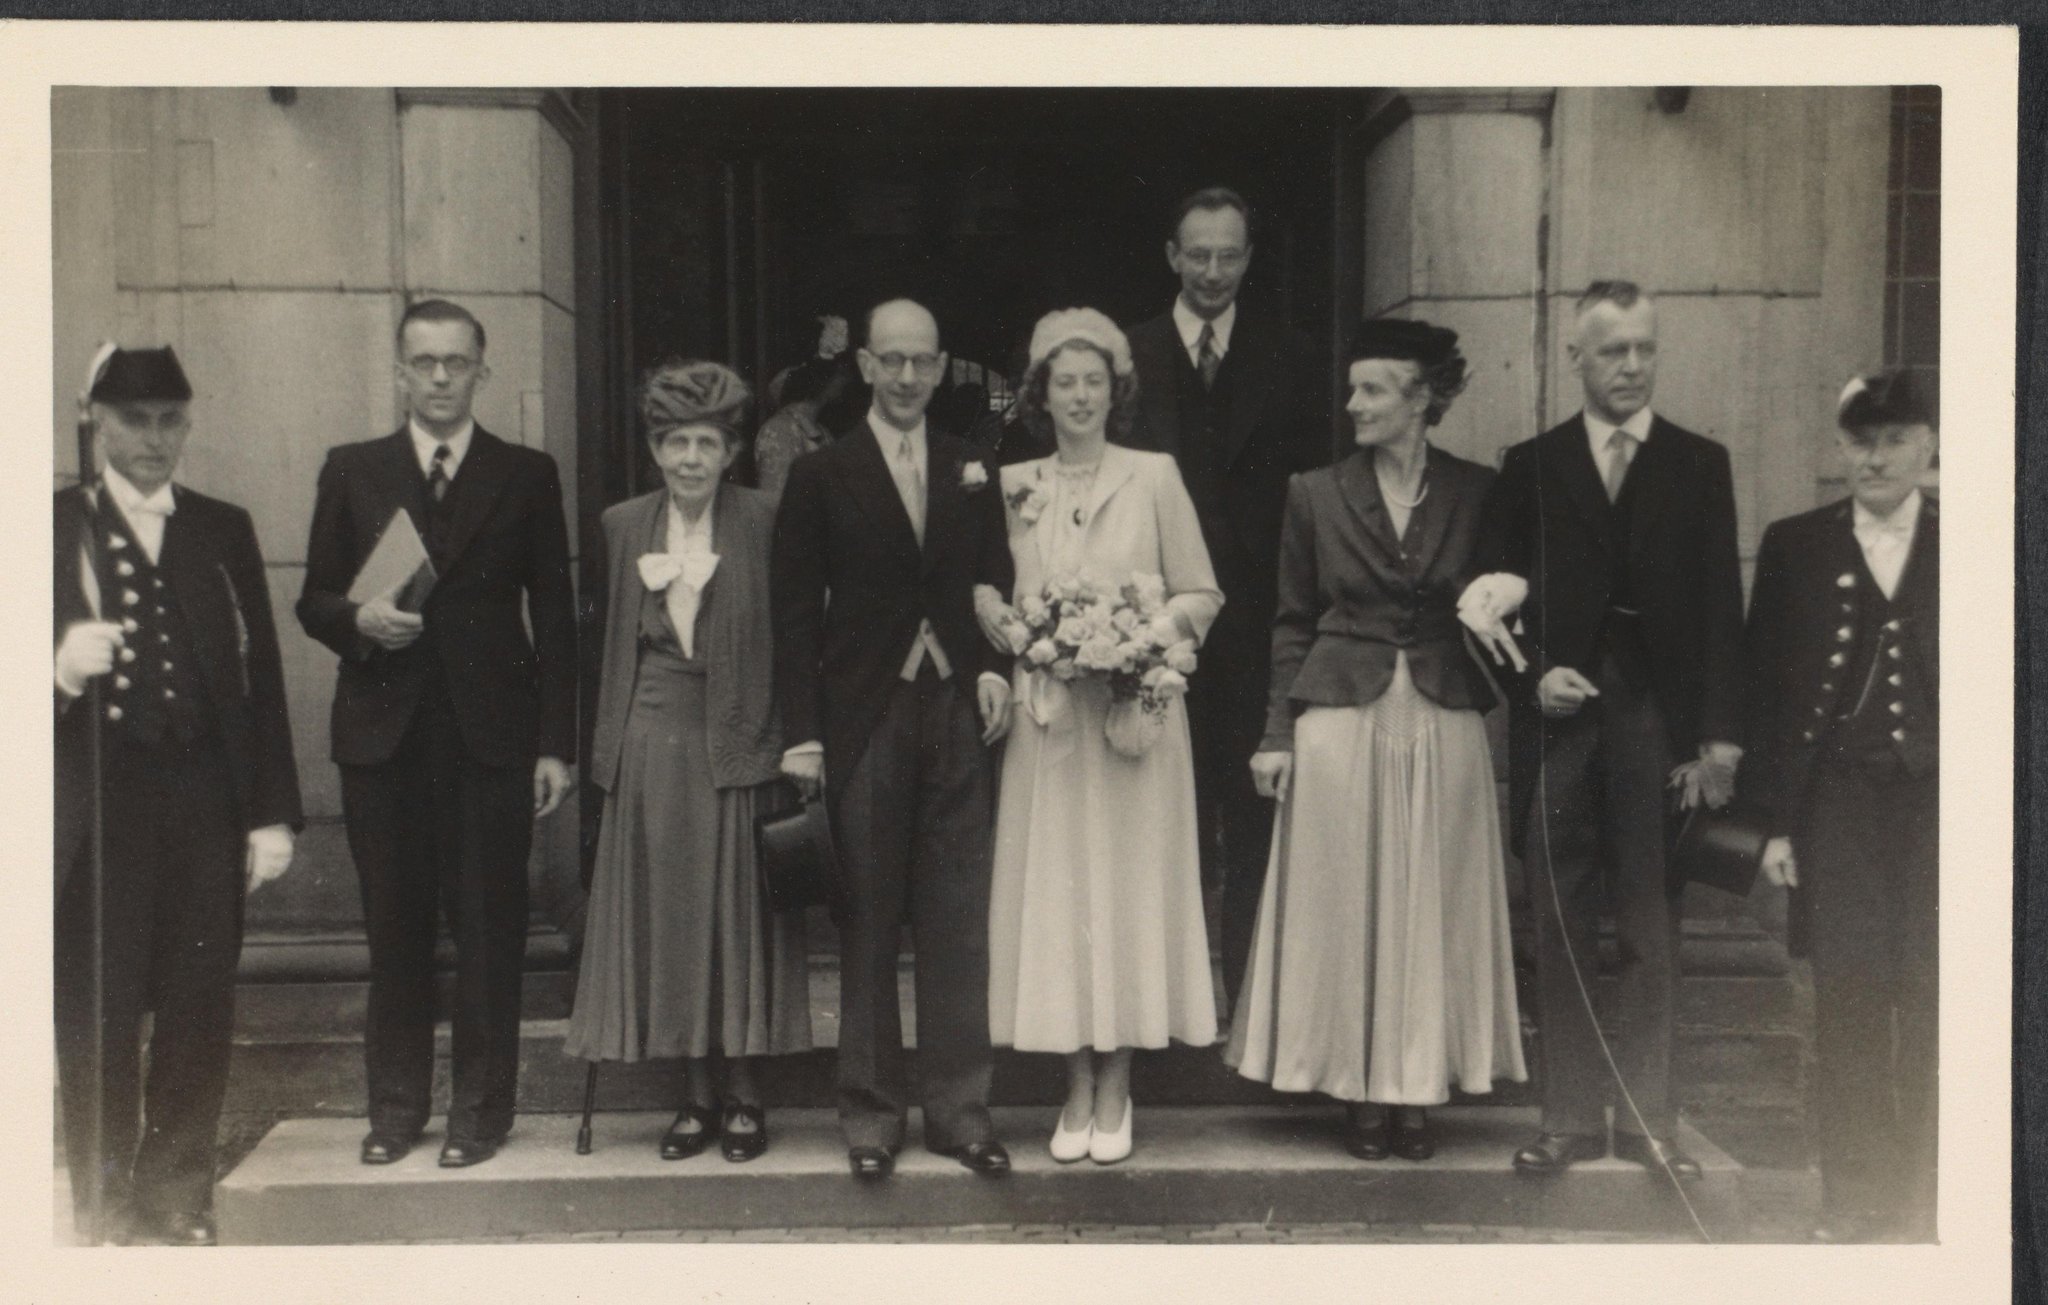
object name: photograph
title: Huwelijksportret van het echtpaar Feenstra-Von Saher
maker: joop colson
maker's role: fotograaf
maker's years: 1901-1966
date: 1948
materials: photographic support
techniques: gelatin silver print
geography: amsterdam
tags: bride and groom in wedding-dress, amsterdam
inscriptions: name: ‘J. Colson Fotograaf aan de Burgerl. Stand [...] O.Z. Voorburgwal 189 - Telef. 48955 Amsterdam-C.’, inscription: ‘huwelijk Feenstra-von Saher 1948’